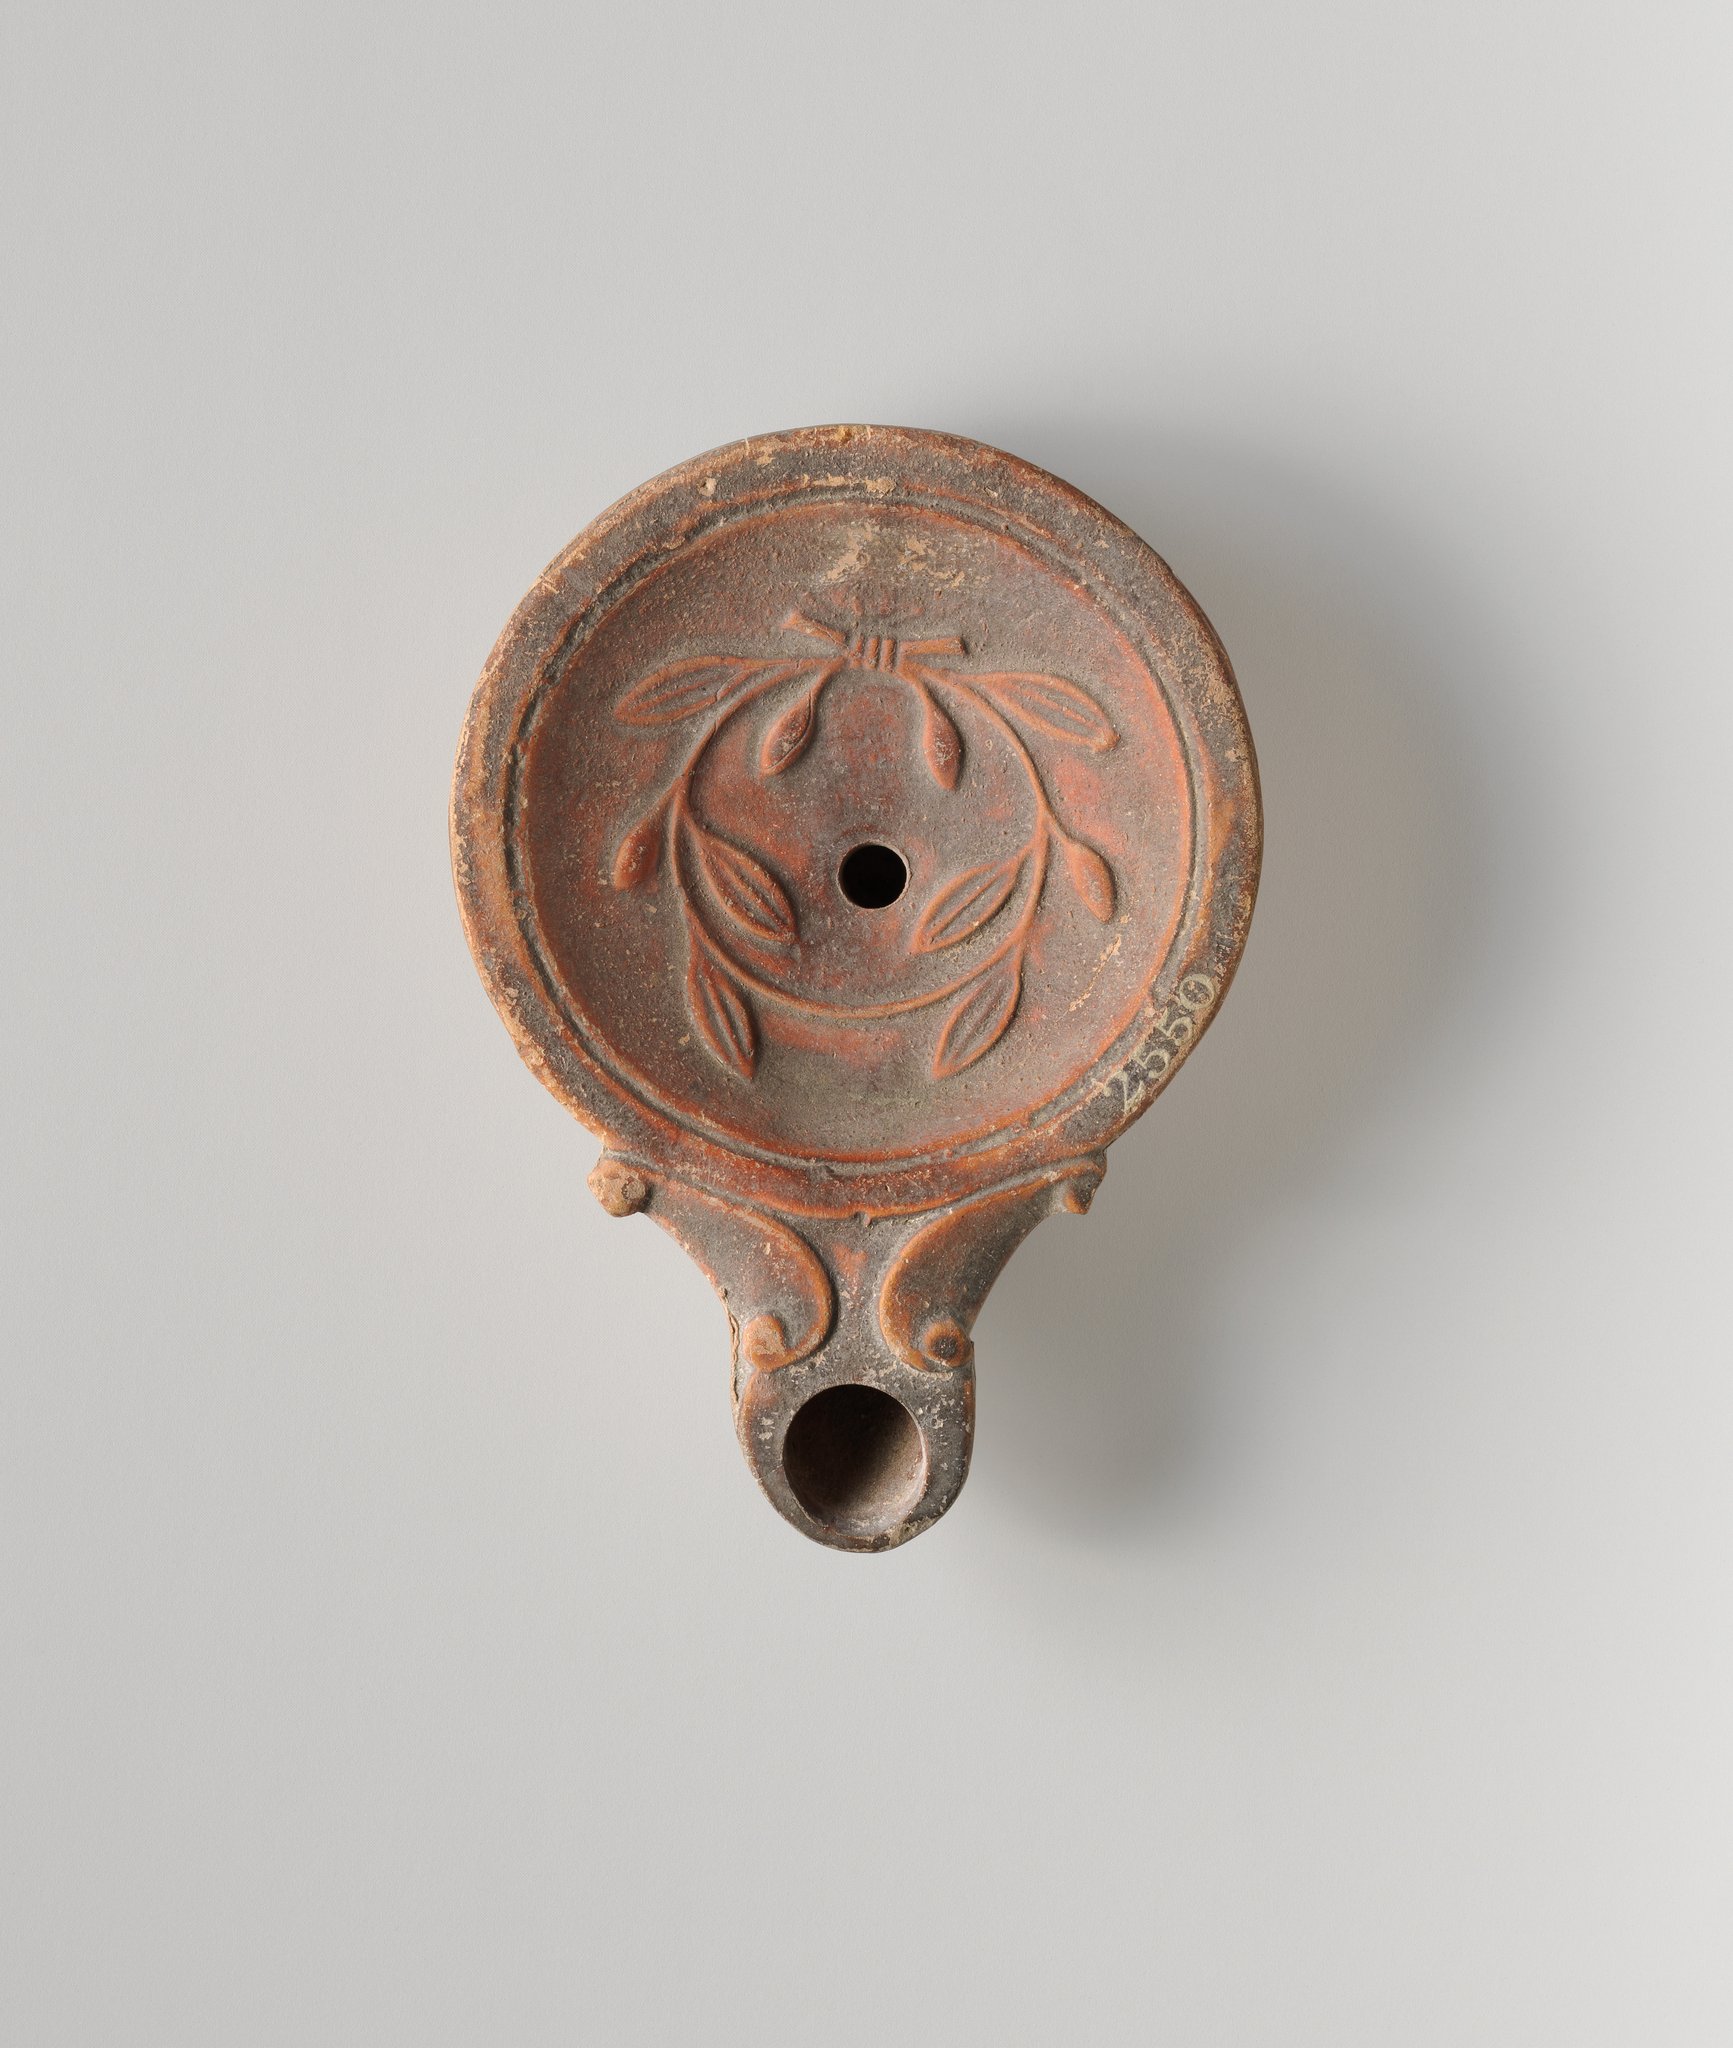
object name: lamp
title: Terracotta oil lamp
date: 40-100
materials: terracotta